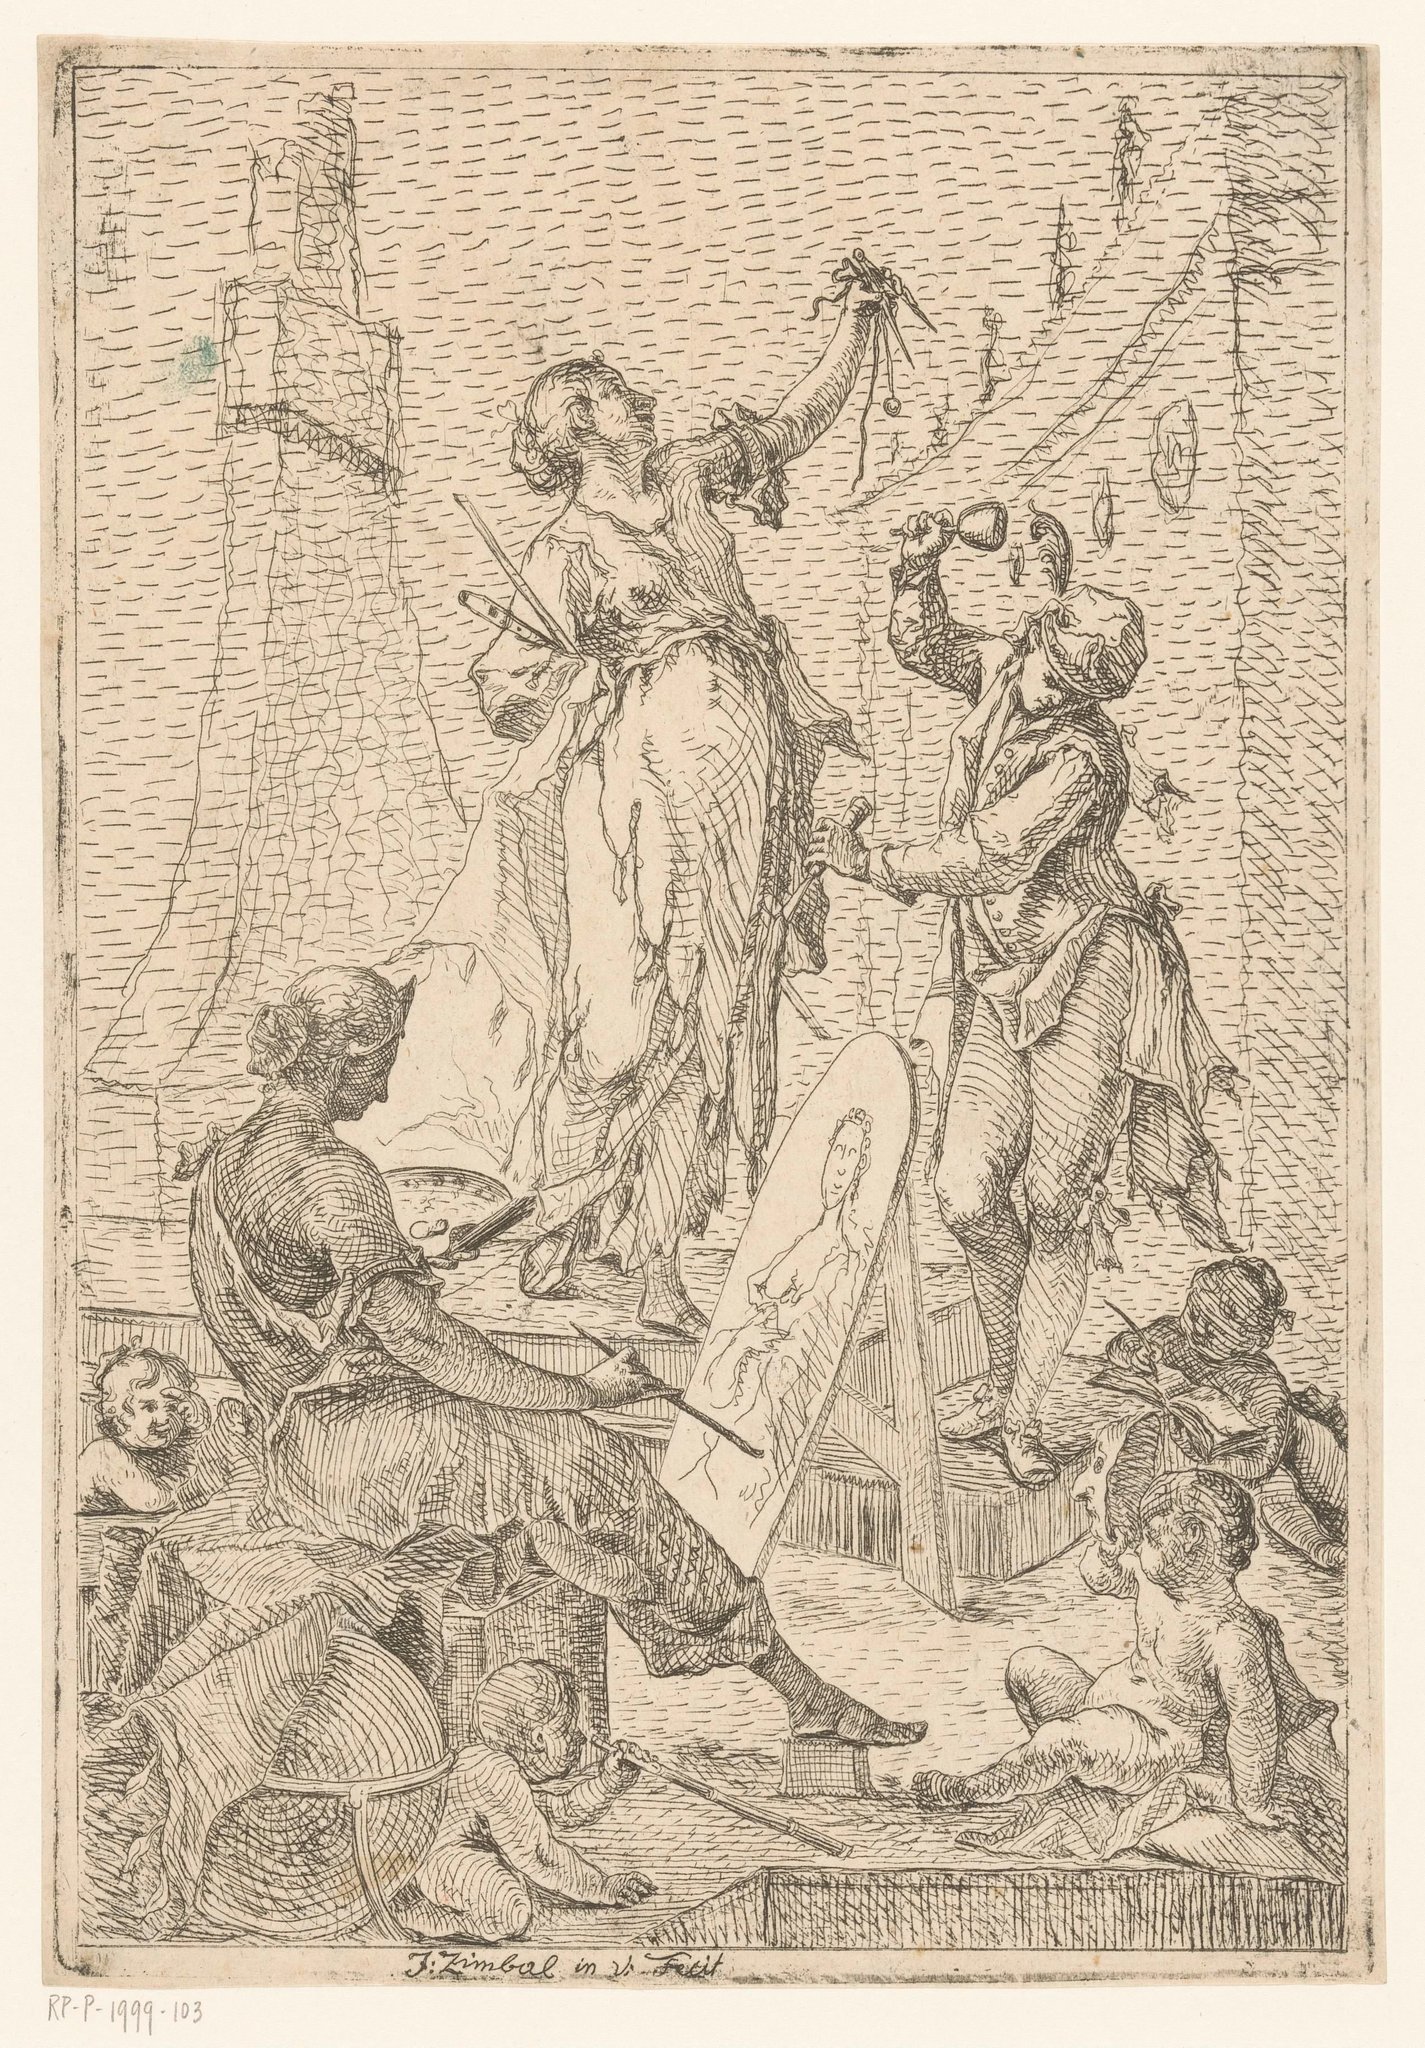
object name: print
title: Allegorie op de schilderkunst, beeldhouwkunst en architectuur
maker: johann cimbal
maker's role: print maker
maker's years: 1722-1795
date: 1732-1795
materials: paper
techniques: etching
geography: germany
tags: tools, aids, implements ~ crafts and industries: chisel, art, easel, sculpture, architecture, cupids: 'amores', 'amoretti', 'putti'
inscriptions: collector's mark, collector's mark: Lugt 2760, collector's mark: Lugt 2228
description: Op de voorgrond de schilderkunst: vrouwenfiguur achter ezel, palet en penseel in de hand, omringd door putti. Op het tweede plan rechts een jonge beeldhouwer, met beitel en hamer werkend aan een standbeeld (vrouw met meetinstrumenten in de handen); daarachter een gedenkteken en een halfronde muur om de architectuur te representeren.